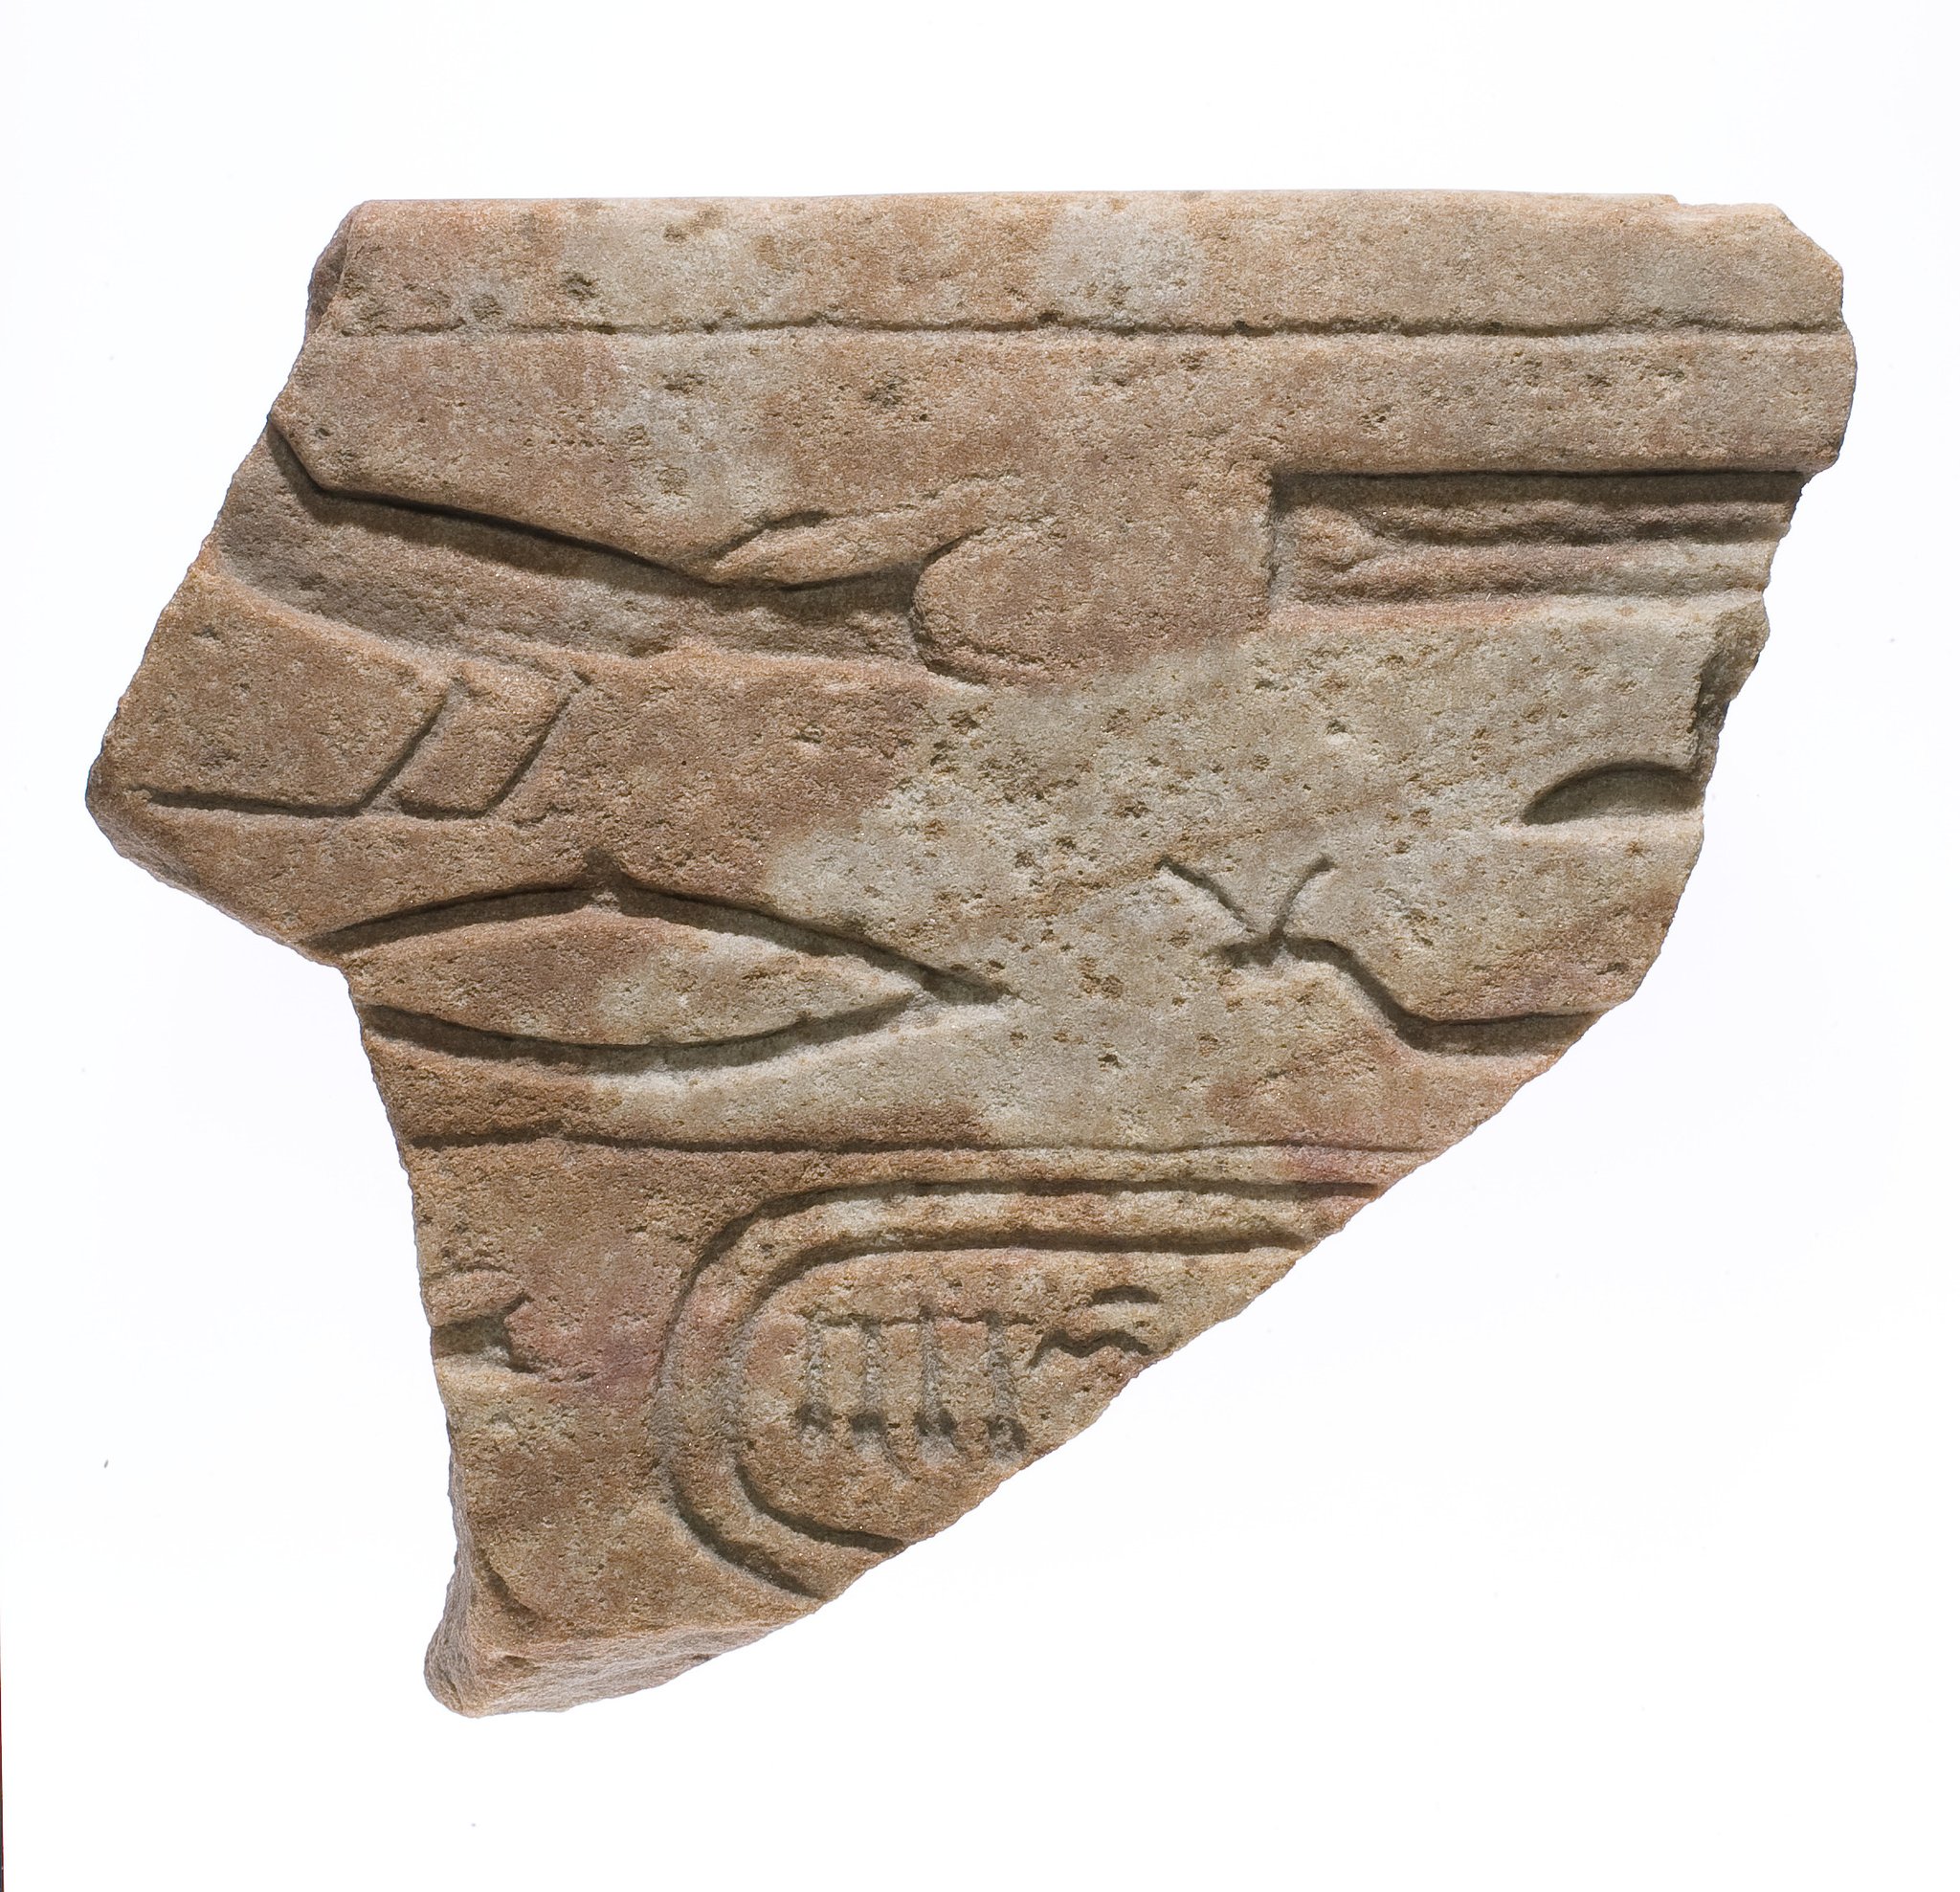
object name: edge of a block with cartouche of nefertiti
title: Block fragment with cartouche of Nefertiti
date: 1353-1336 BCE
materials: quartzite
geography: egypt